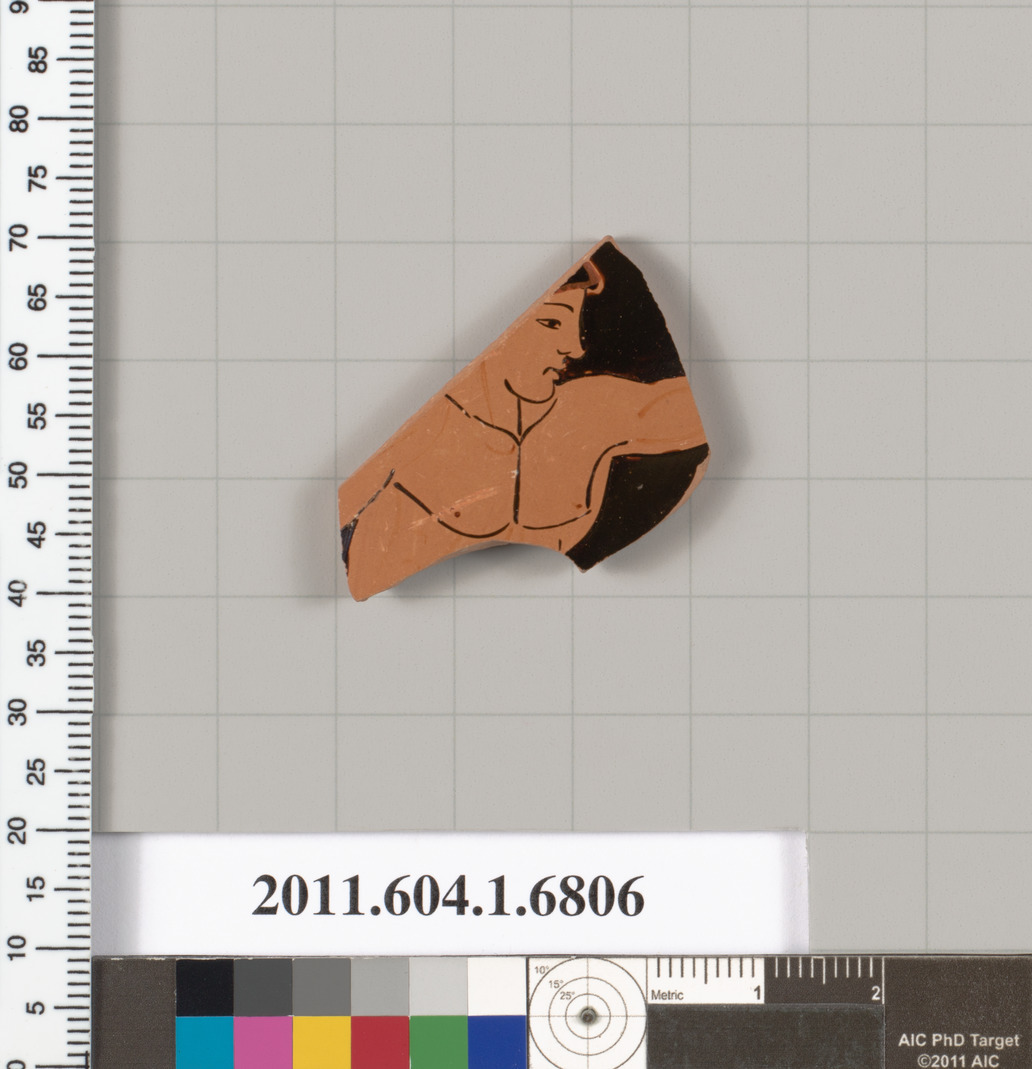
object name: kylix fragment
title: Terracotta fragment of a kylix (drinking cup)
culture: greek, attic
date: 490-470 BCE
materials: terracotta